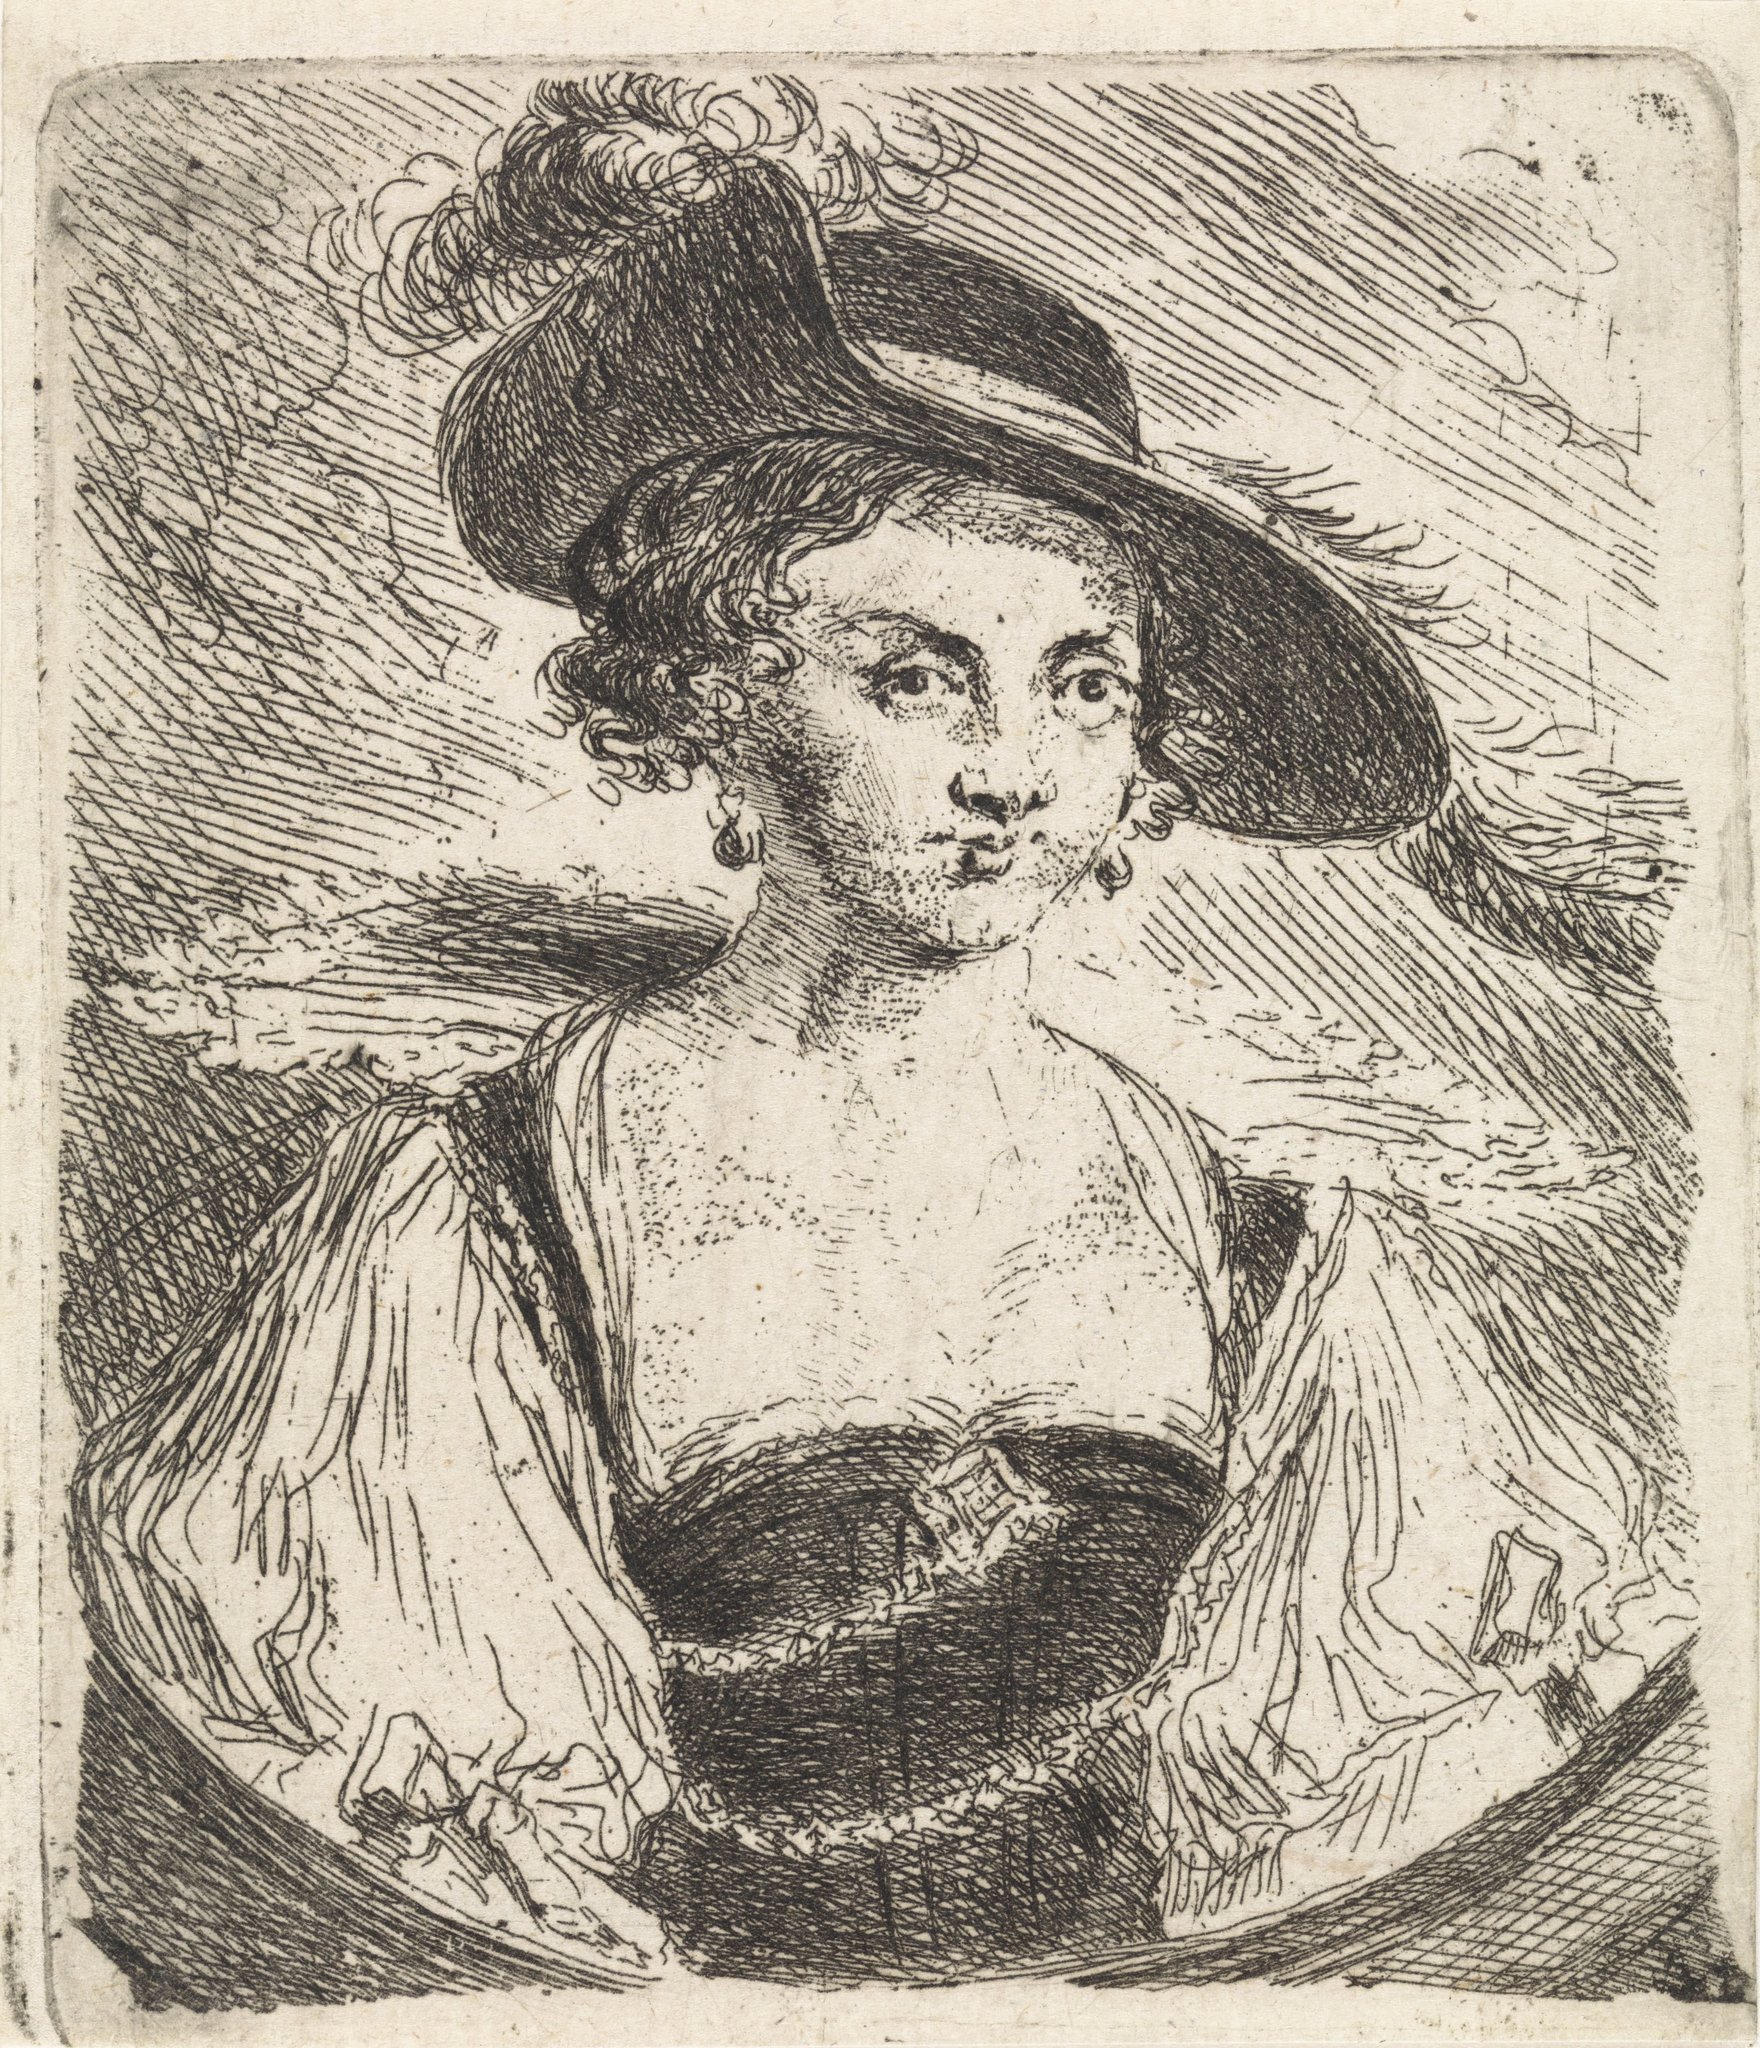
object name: print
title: Portret van Helena Fourment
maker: philippe lambert joseph spruyt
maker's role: print maker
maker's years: 1727-1801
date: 1747-1801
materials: paper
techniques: etching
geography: ghent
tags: antwerp, head-gear: hat (+ women's clothes)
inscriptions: collector's mark: Lugt 240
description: Portret van Helena Fourment, de tweede echtgenote van de schilder Rubens, met een breedgerande hoed op het hoofd.